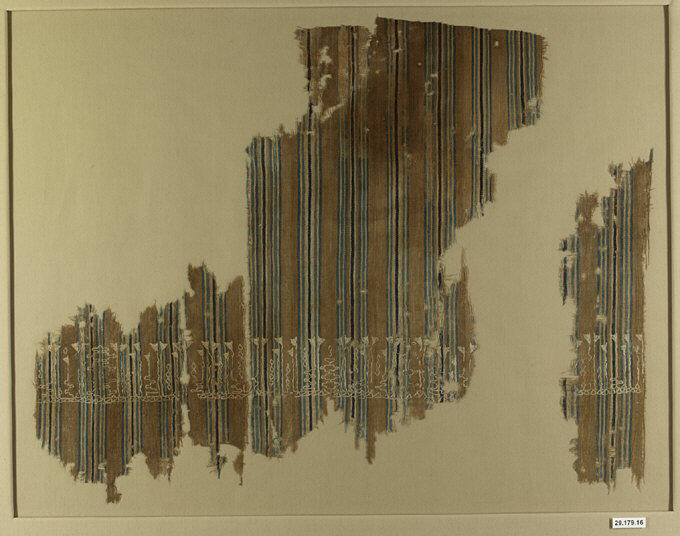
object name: textile fragment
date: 901-1000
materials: cotton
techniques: dyeing, embroidery, weave, resist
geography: yemen